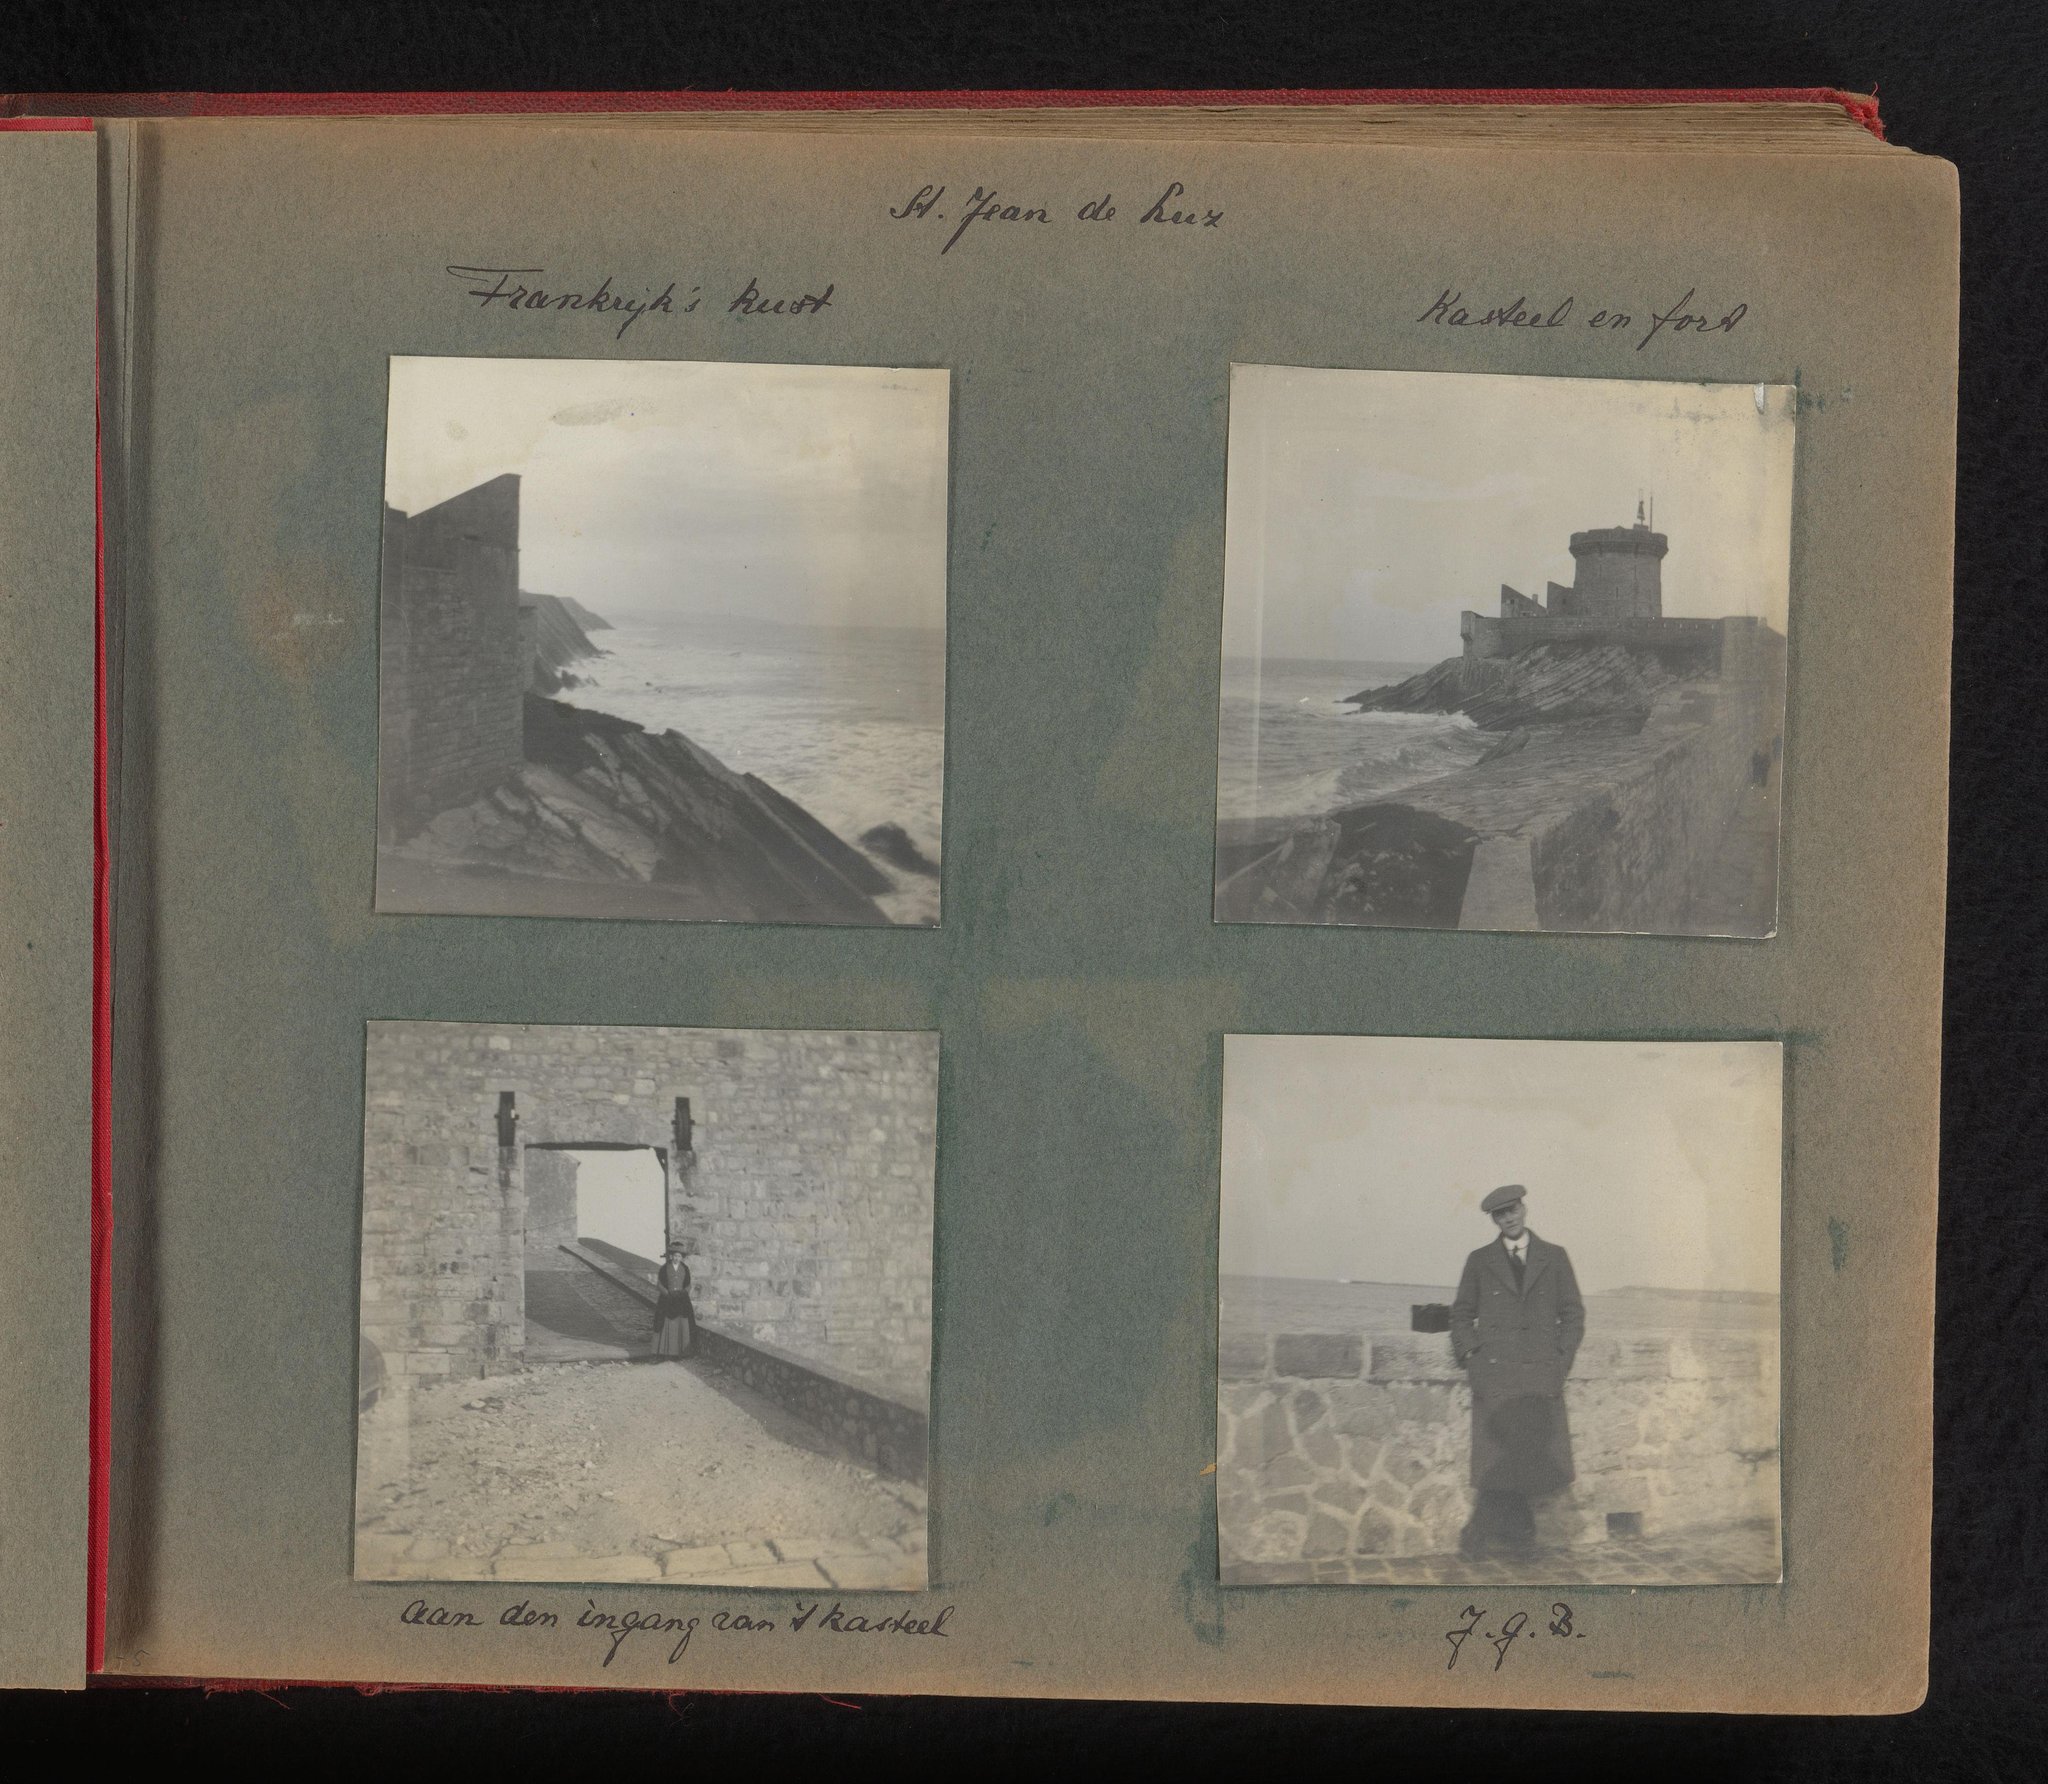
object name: photograph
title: St. Jean de Luz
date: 1911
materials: paper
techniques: gelatin silver print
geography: saint-jean-de-luz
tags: charlotte alida boelen-matthes (lot), amsterdam, joan gerard boelen, fortress, ocean, beach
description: Deze foto's zijn onderdeel van een album.